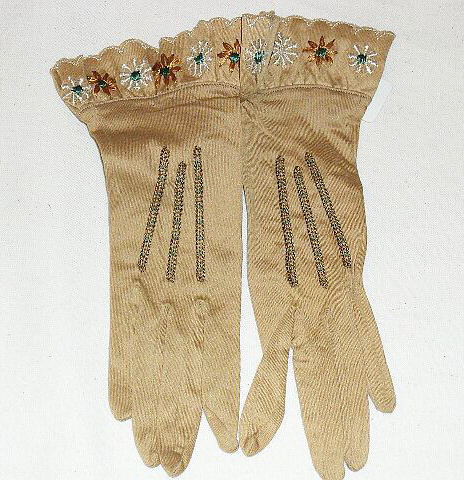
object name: glove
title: Gloves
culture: american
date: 1880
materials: cotton